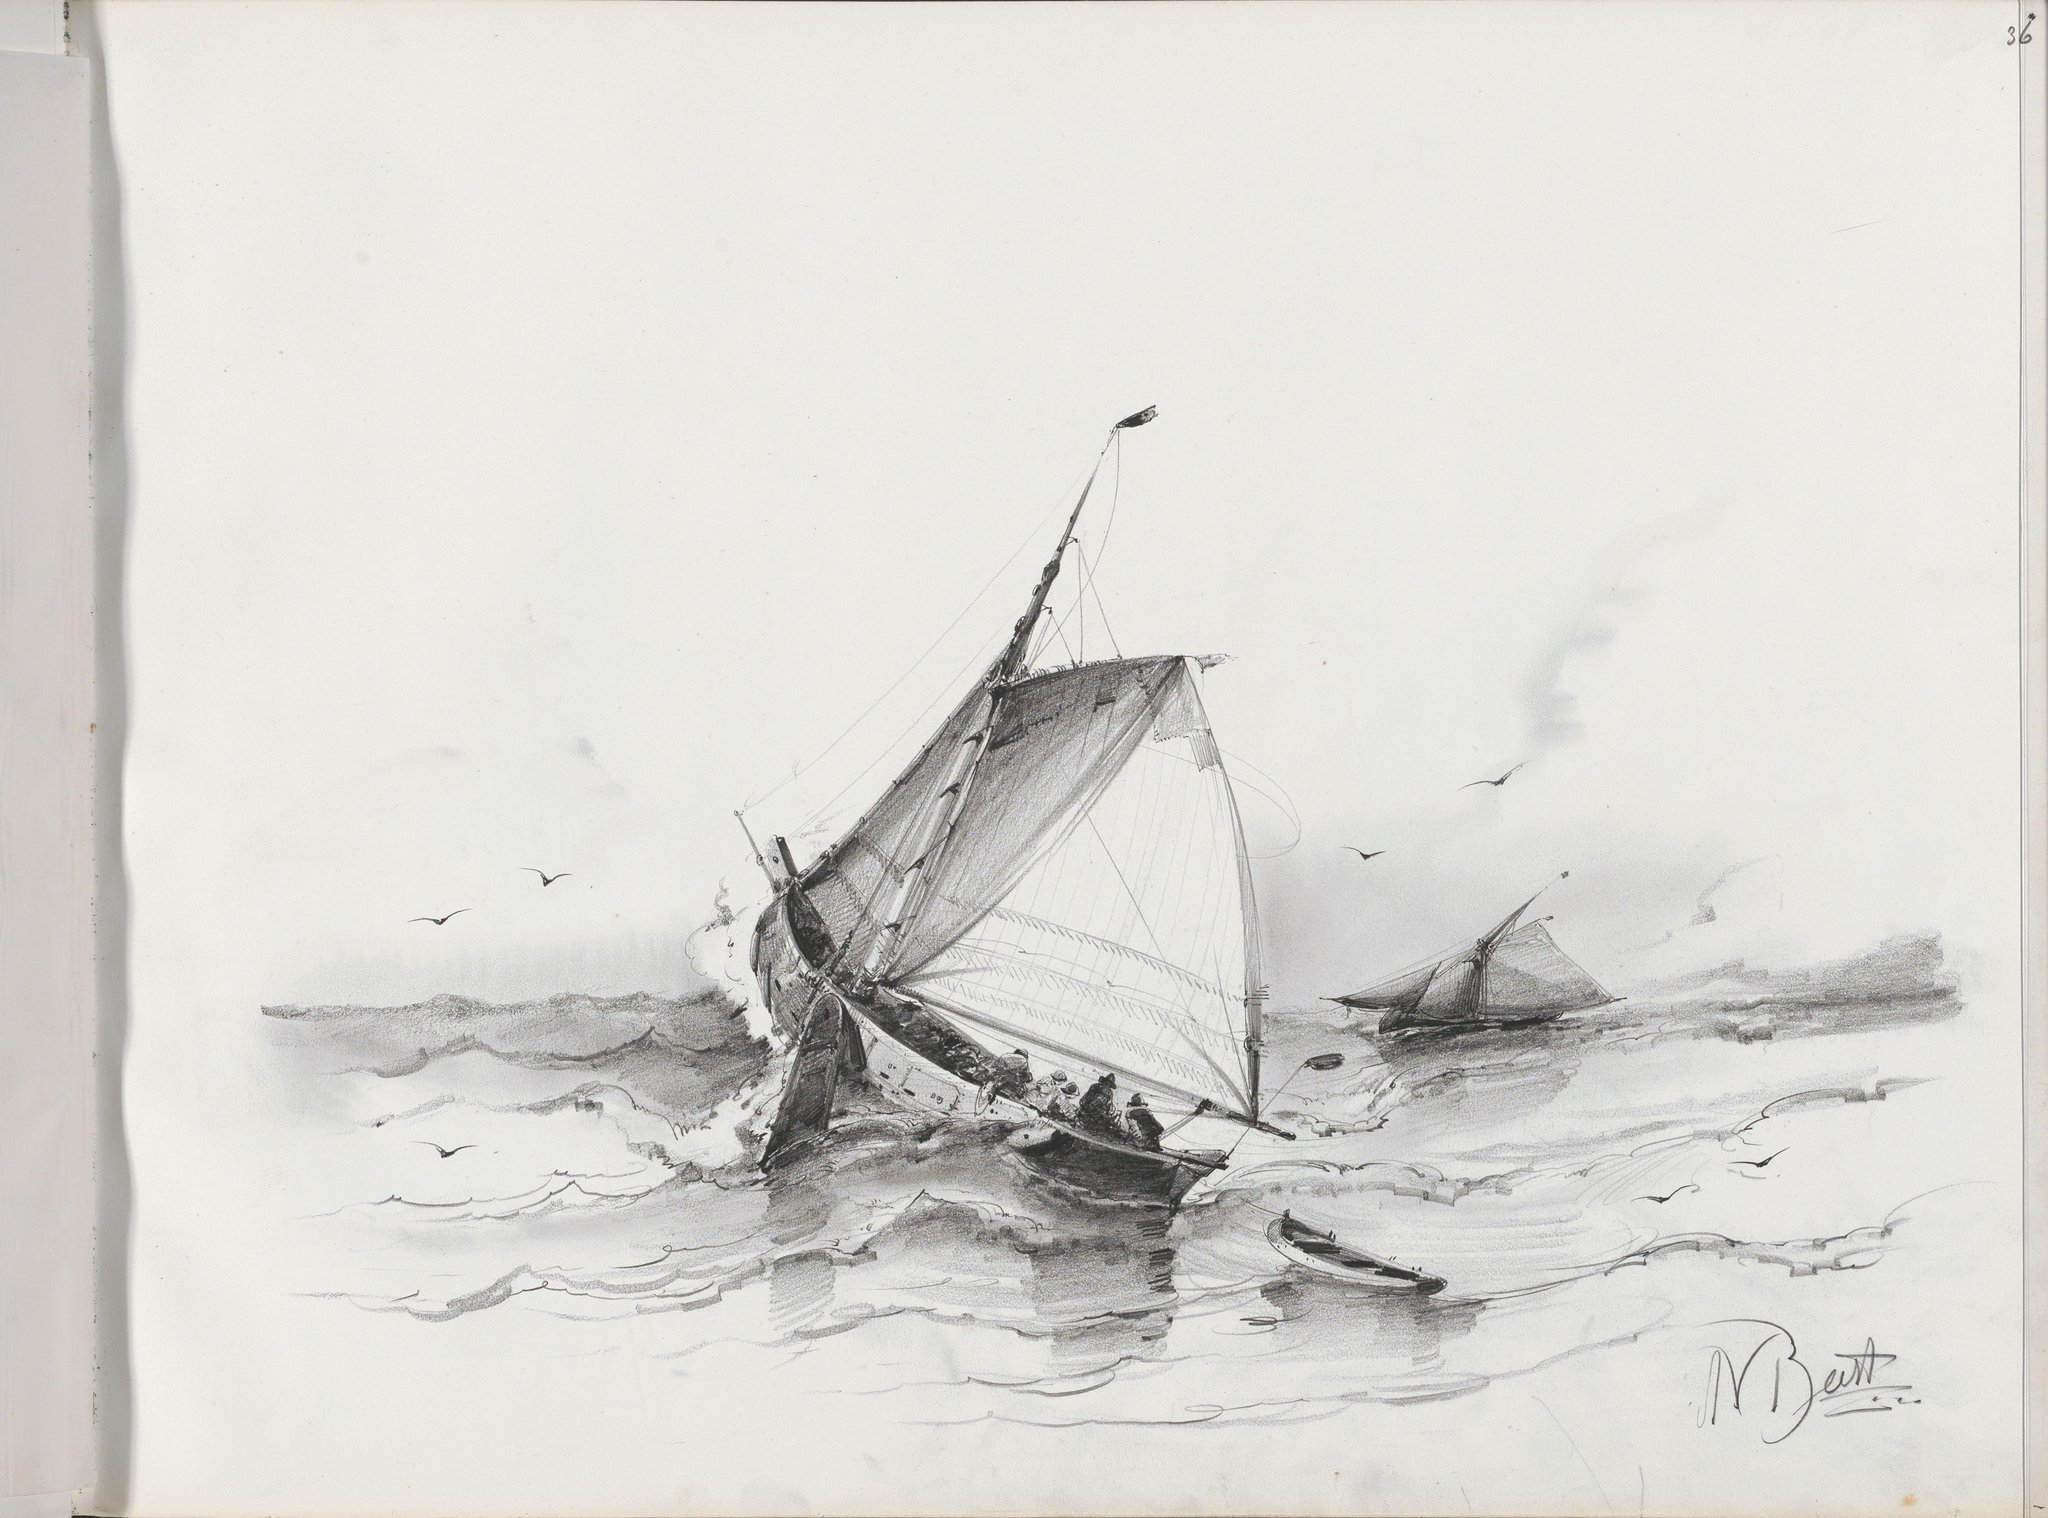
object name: sketchbook leaf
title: Figuren in een zeilboot op een woelige zee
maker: albertus van beest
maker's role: draughtsman, print maker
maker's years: 1820-1860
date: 1830-1860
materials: paper, pencil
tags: sailing-ship, sailing-boat, landscapes with waters, waterscapes, seascapes (in the temperate zone)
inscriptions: signature: ‘AV Beest’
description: Op de achtergrond een zeilboot. Blad 36 recto uit een schetsboek met 46 bladen.